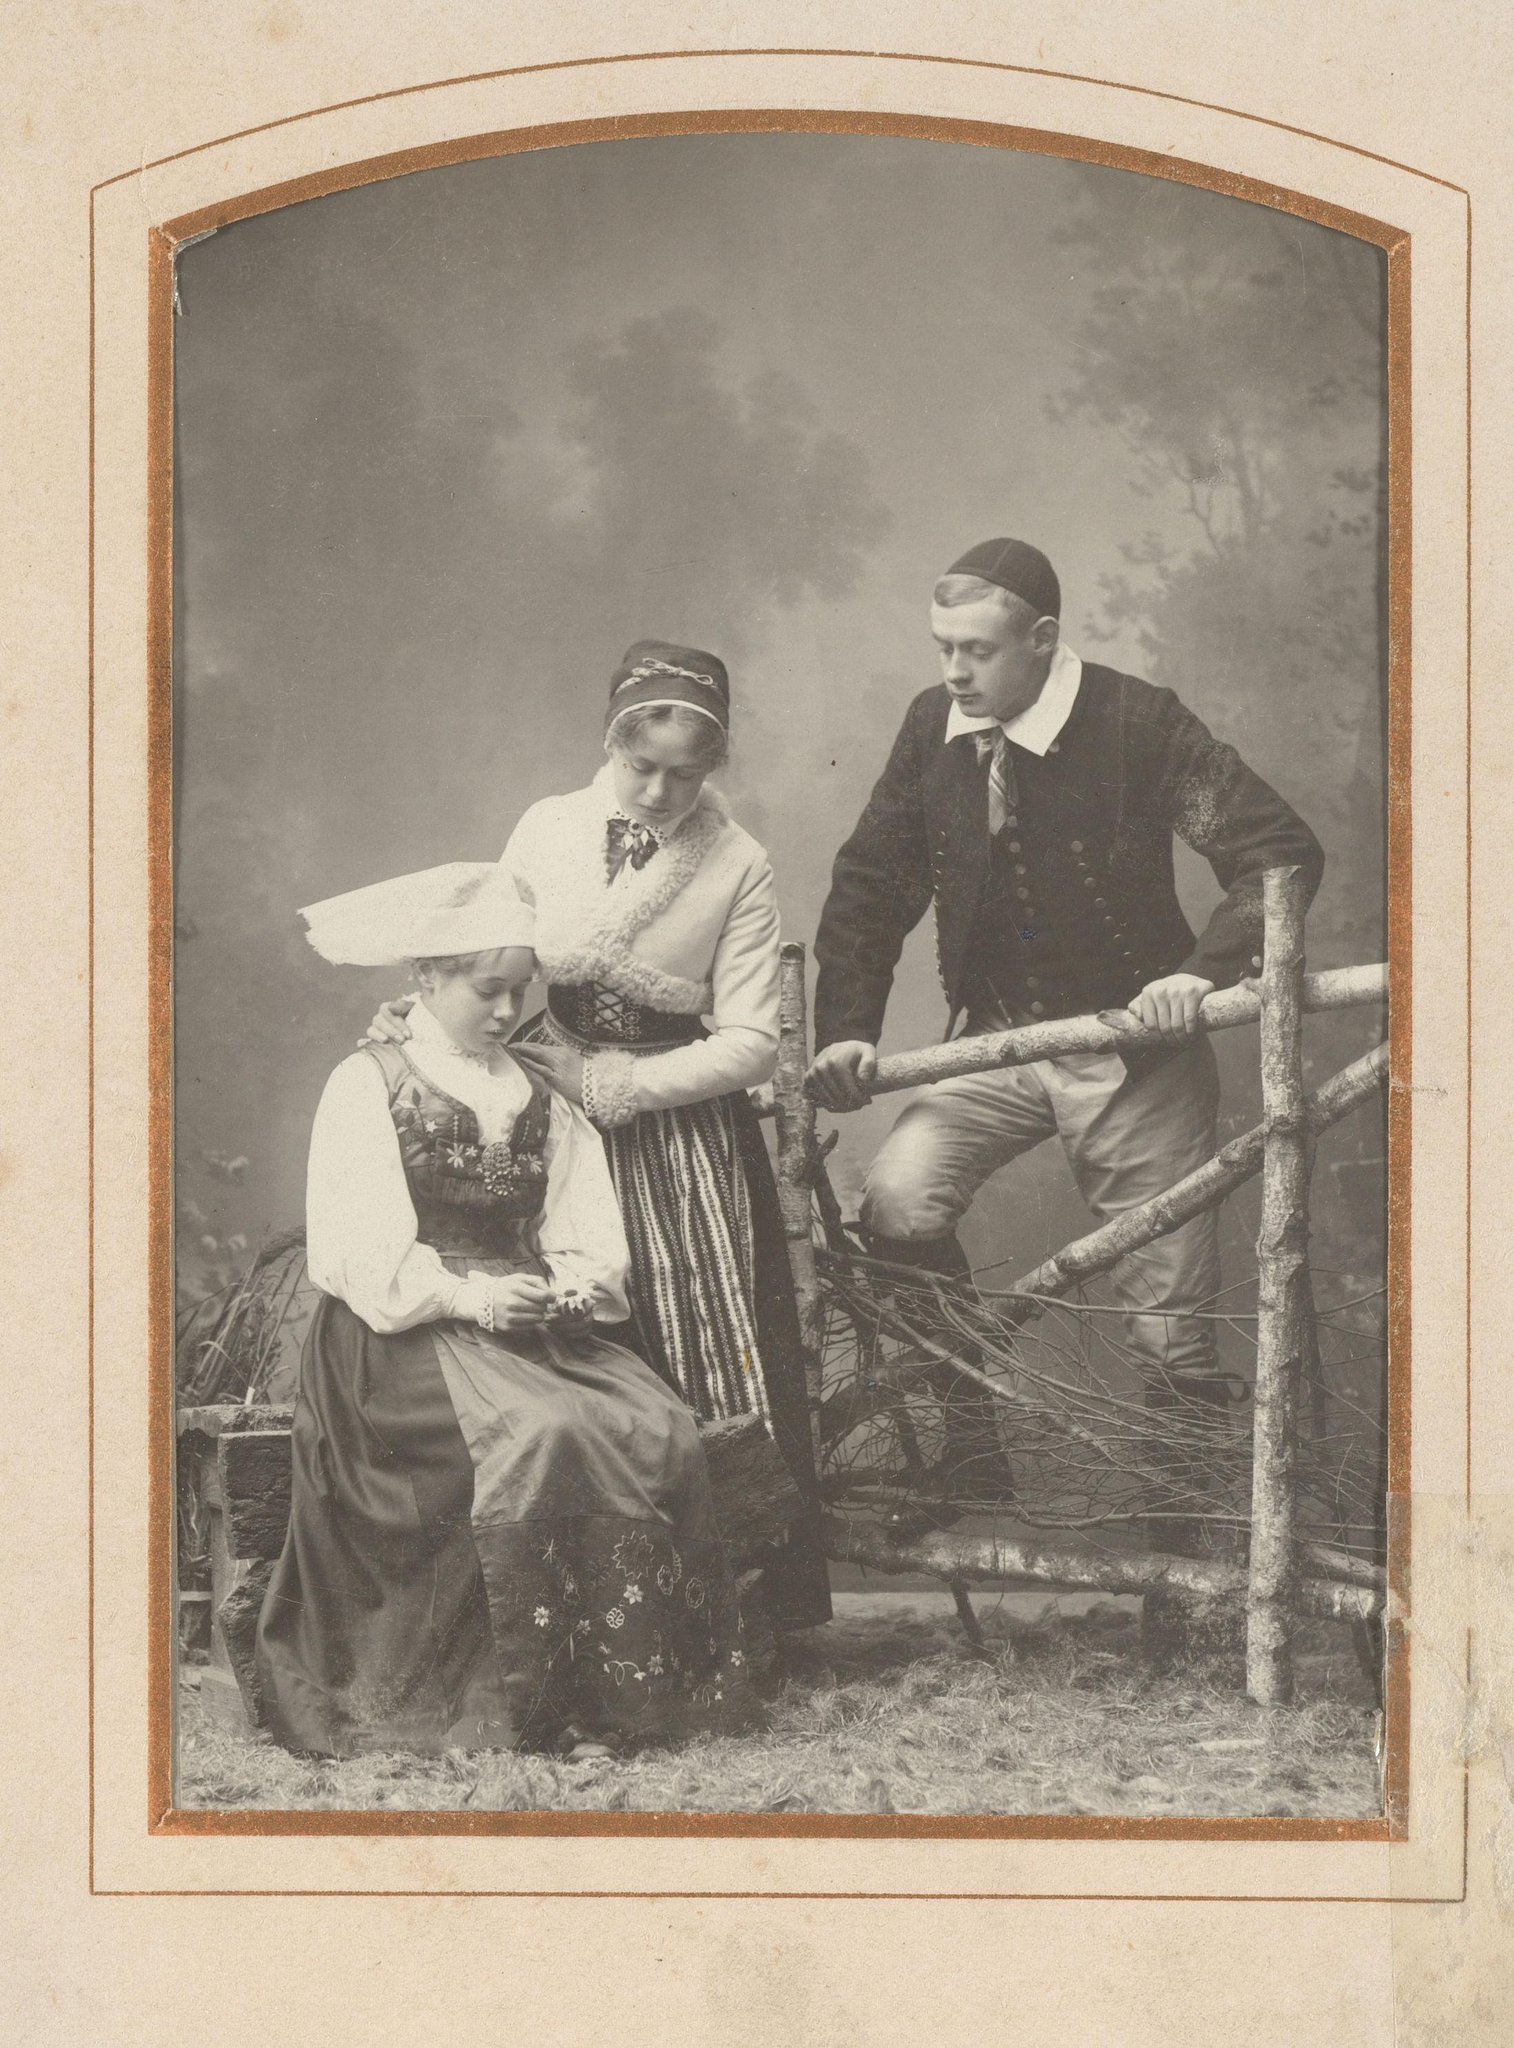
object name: album leaf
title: Portret van twee meisjes en een jongen in klederdracht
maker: carl vilhelm roikjer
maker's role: fotograaf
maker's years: 1842-1902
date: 1896-1920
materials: cardboard, photographic support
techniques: matte daylight collodion silver print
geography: malmö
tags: youth, adolescent, adolescent, young woman, maiden (+ two persons), folk costume, regional costume, anonymous historical persons portrayed in a group, in a group-portrait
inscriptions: name: ‘Anna L.’, inscription: ‘Tillerkänd högsta utdeladepris för/ fotografier Malmö 1891 & 1896./ C. V. Roikjer/ KONGL. HOFFOTOGRAF/ MALMÖ/ 18, SÖDERGATAN 18.’